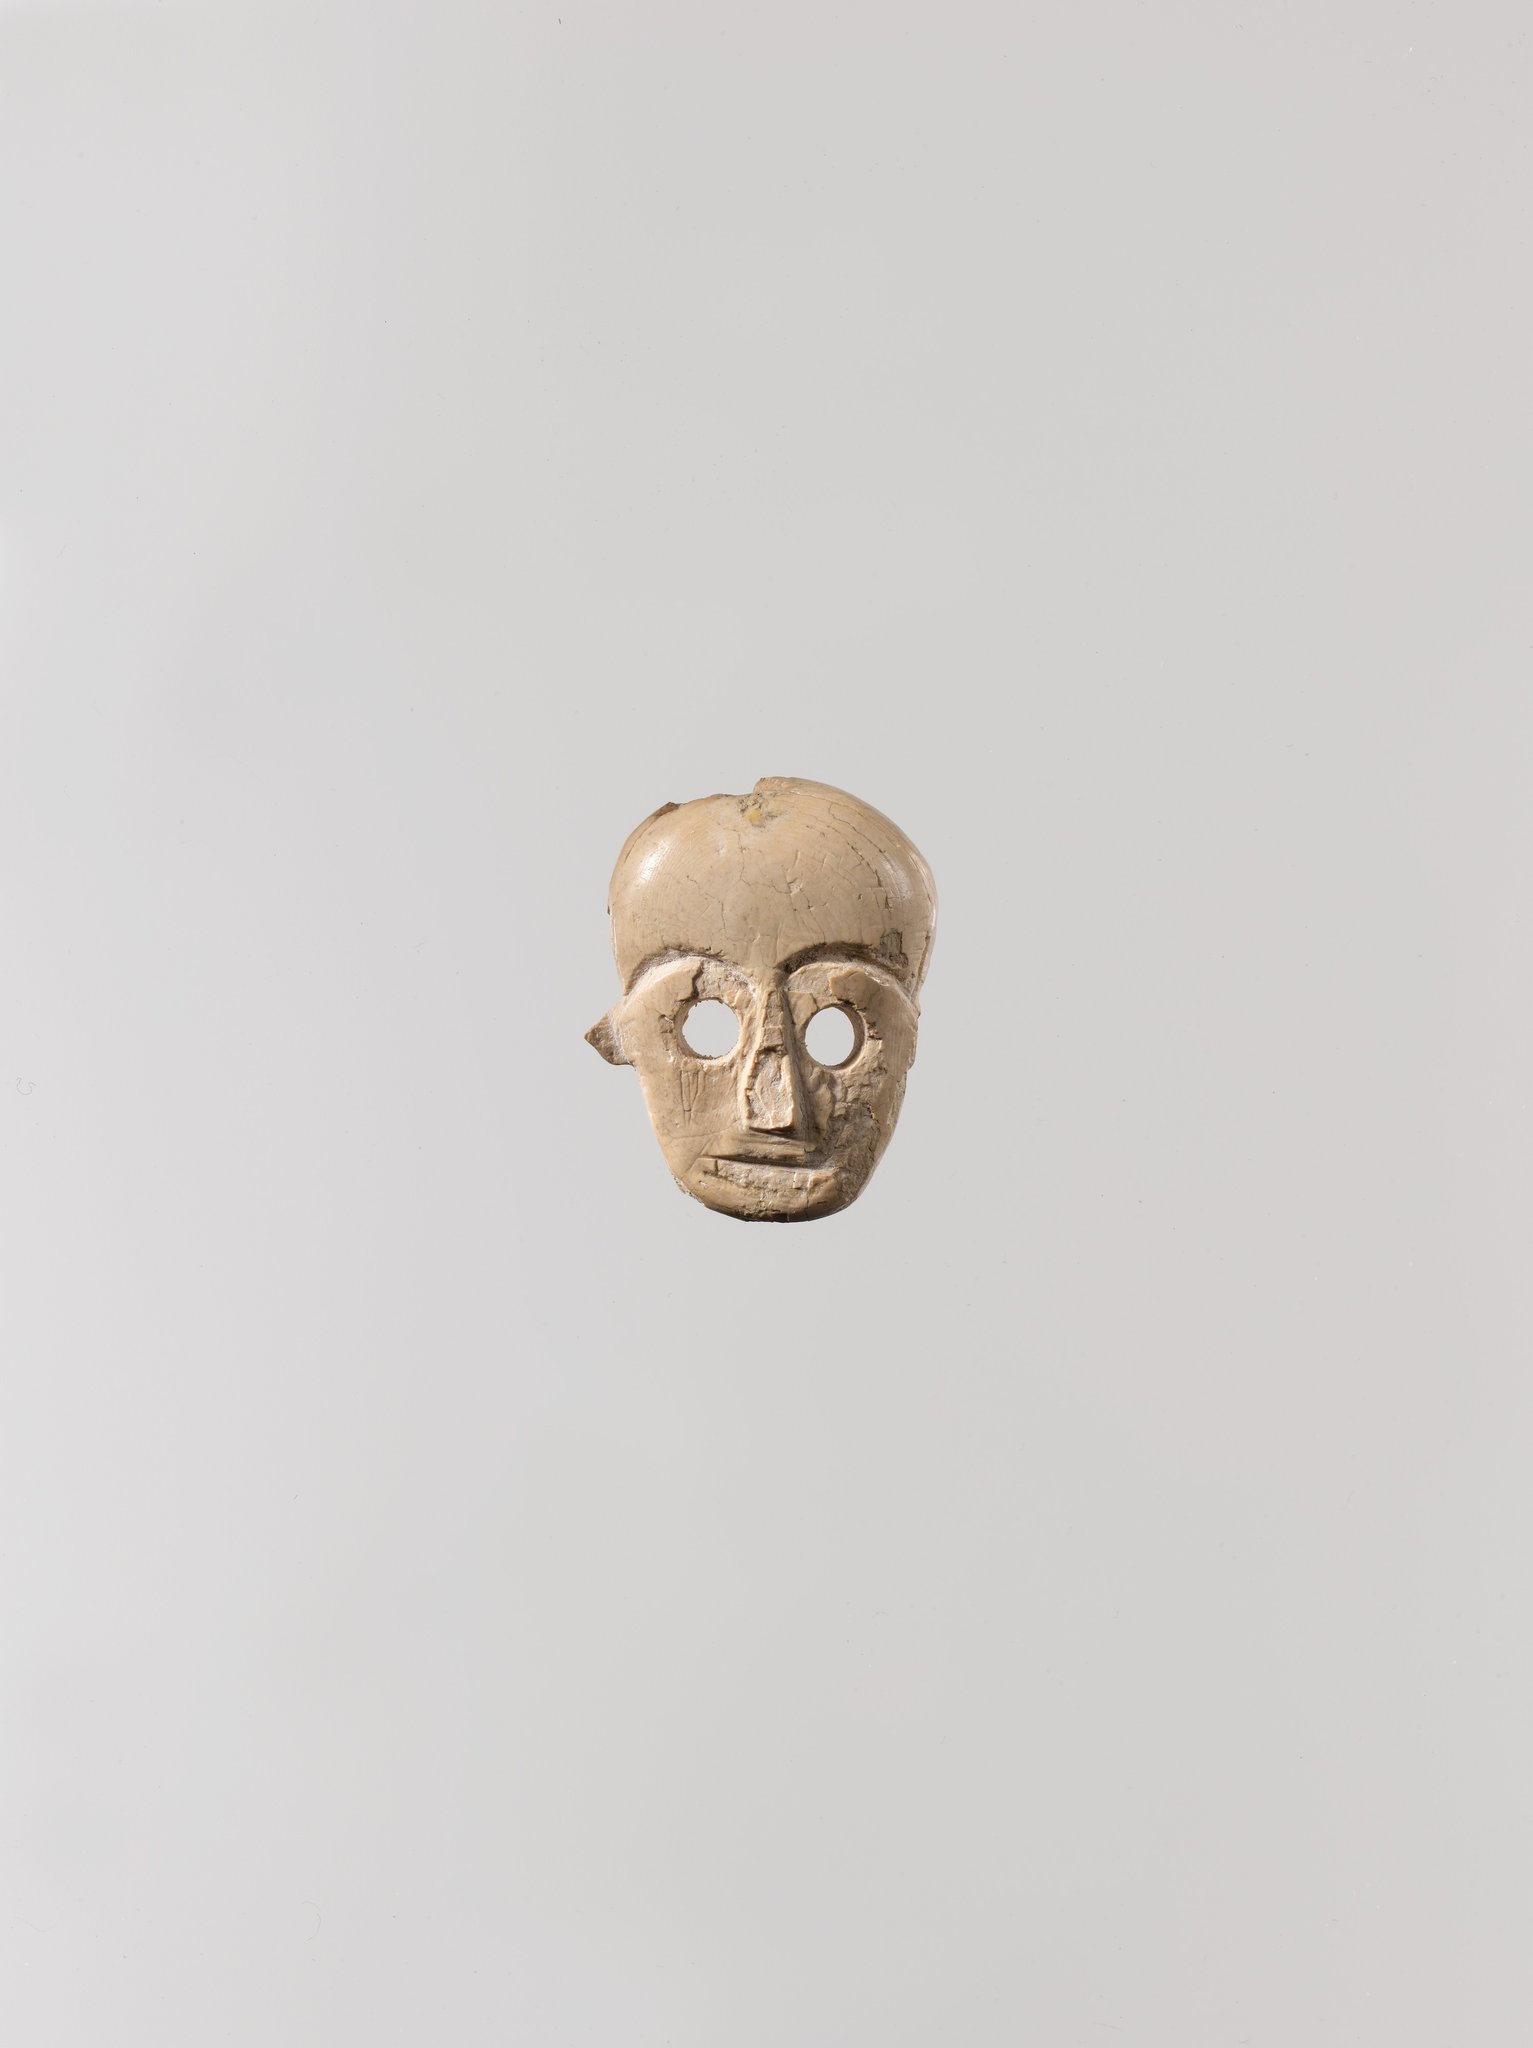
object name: statuette, face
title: Face from a statuette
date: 3300-3100 BCE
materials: ivory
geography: egypt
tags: faces